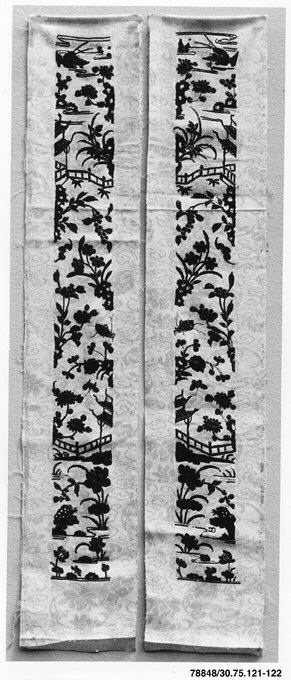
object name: sleeve band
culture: chinese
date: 1801-1900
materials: metal thread, silk